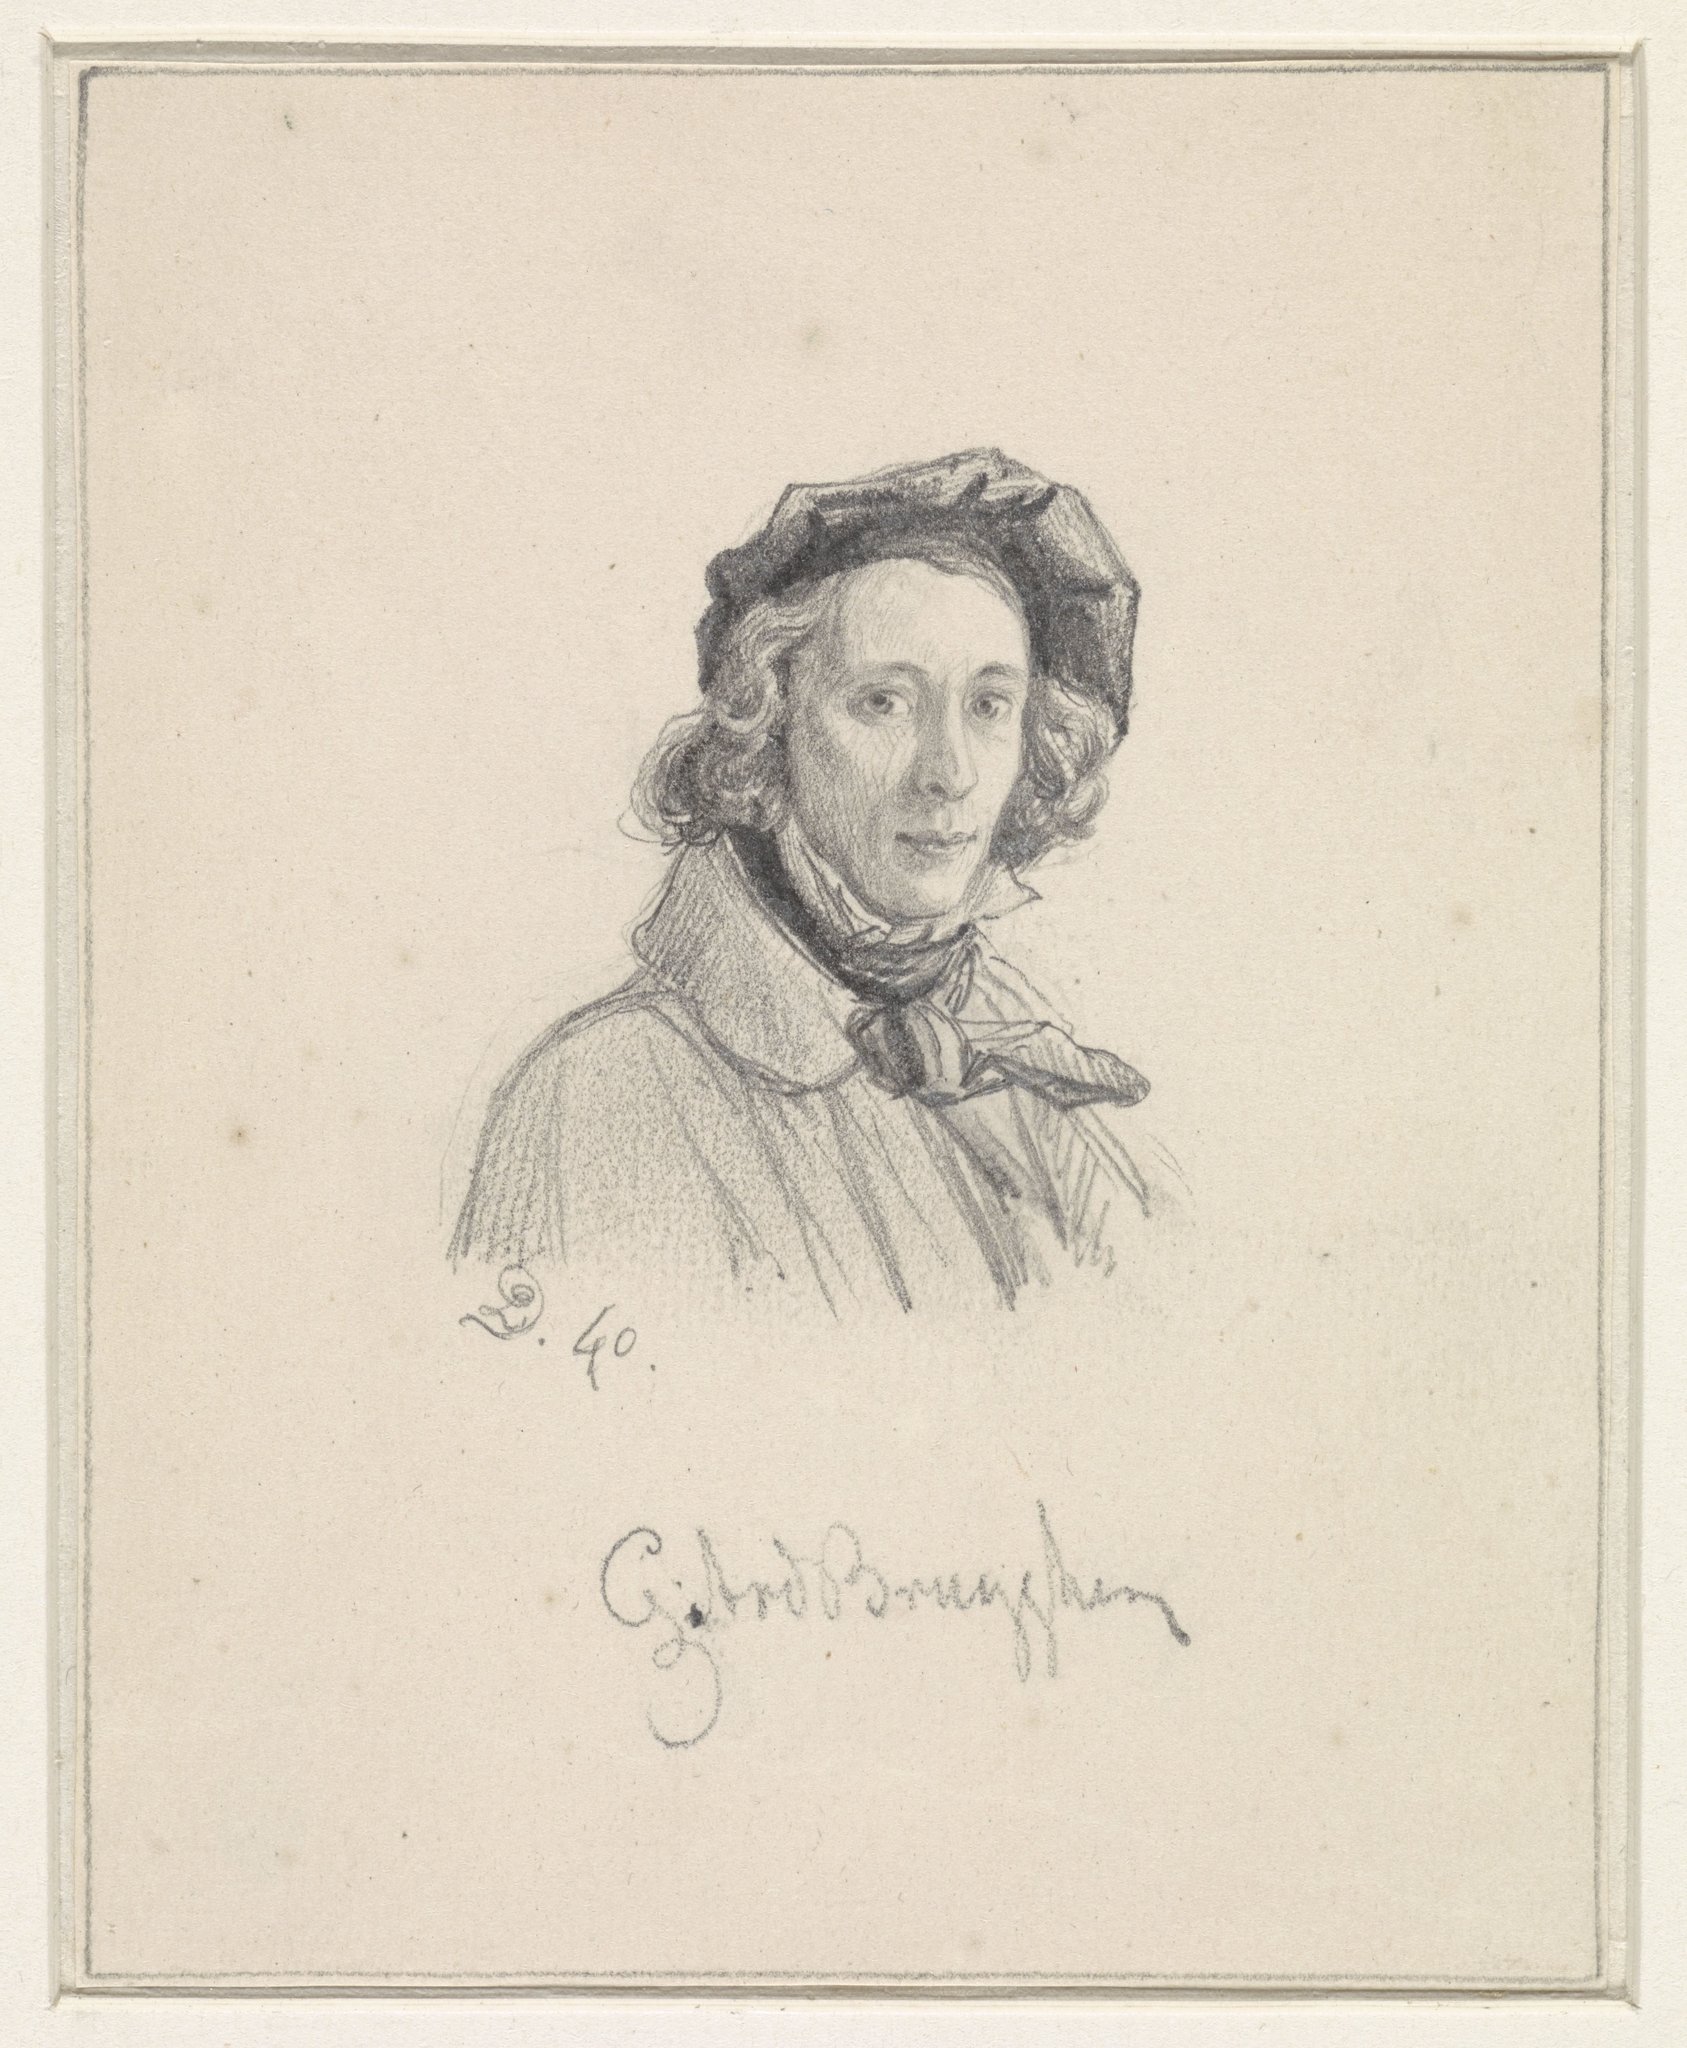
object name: drawing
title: Portret van Guillaume Anne van der Brugghen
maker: monogrammist ld (19e eeuw)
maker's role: draughtsman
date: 1840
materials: paper, pencil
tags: nijmegen, draughtsman, guillaume anne van der brugghen, historical persons, portrait, self-portrait of painter, portrait, self-portrait of artist, portrait, self-portrait of draughtsman